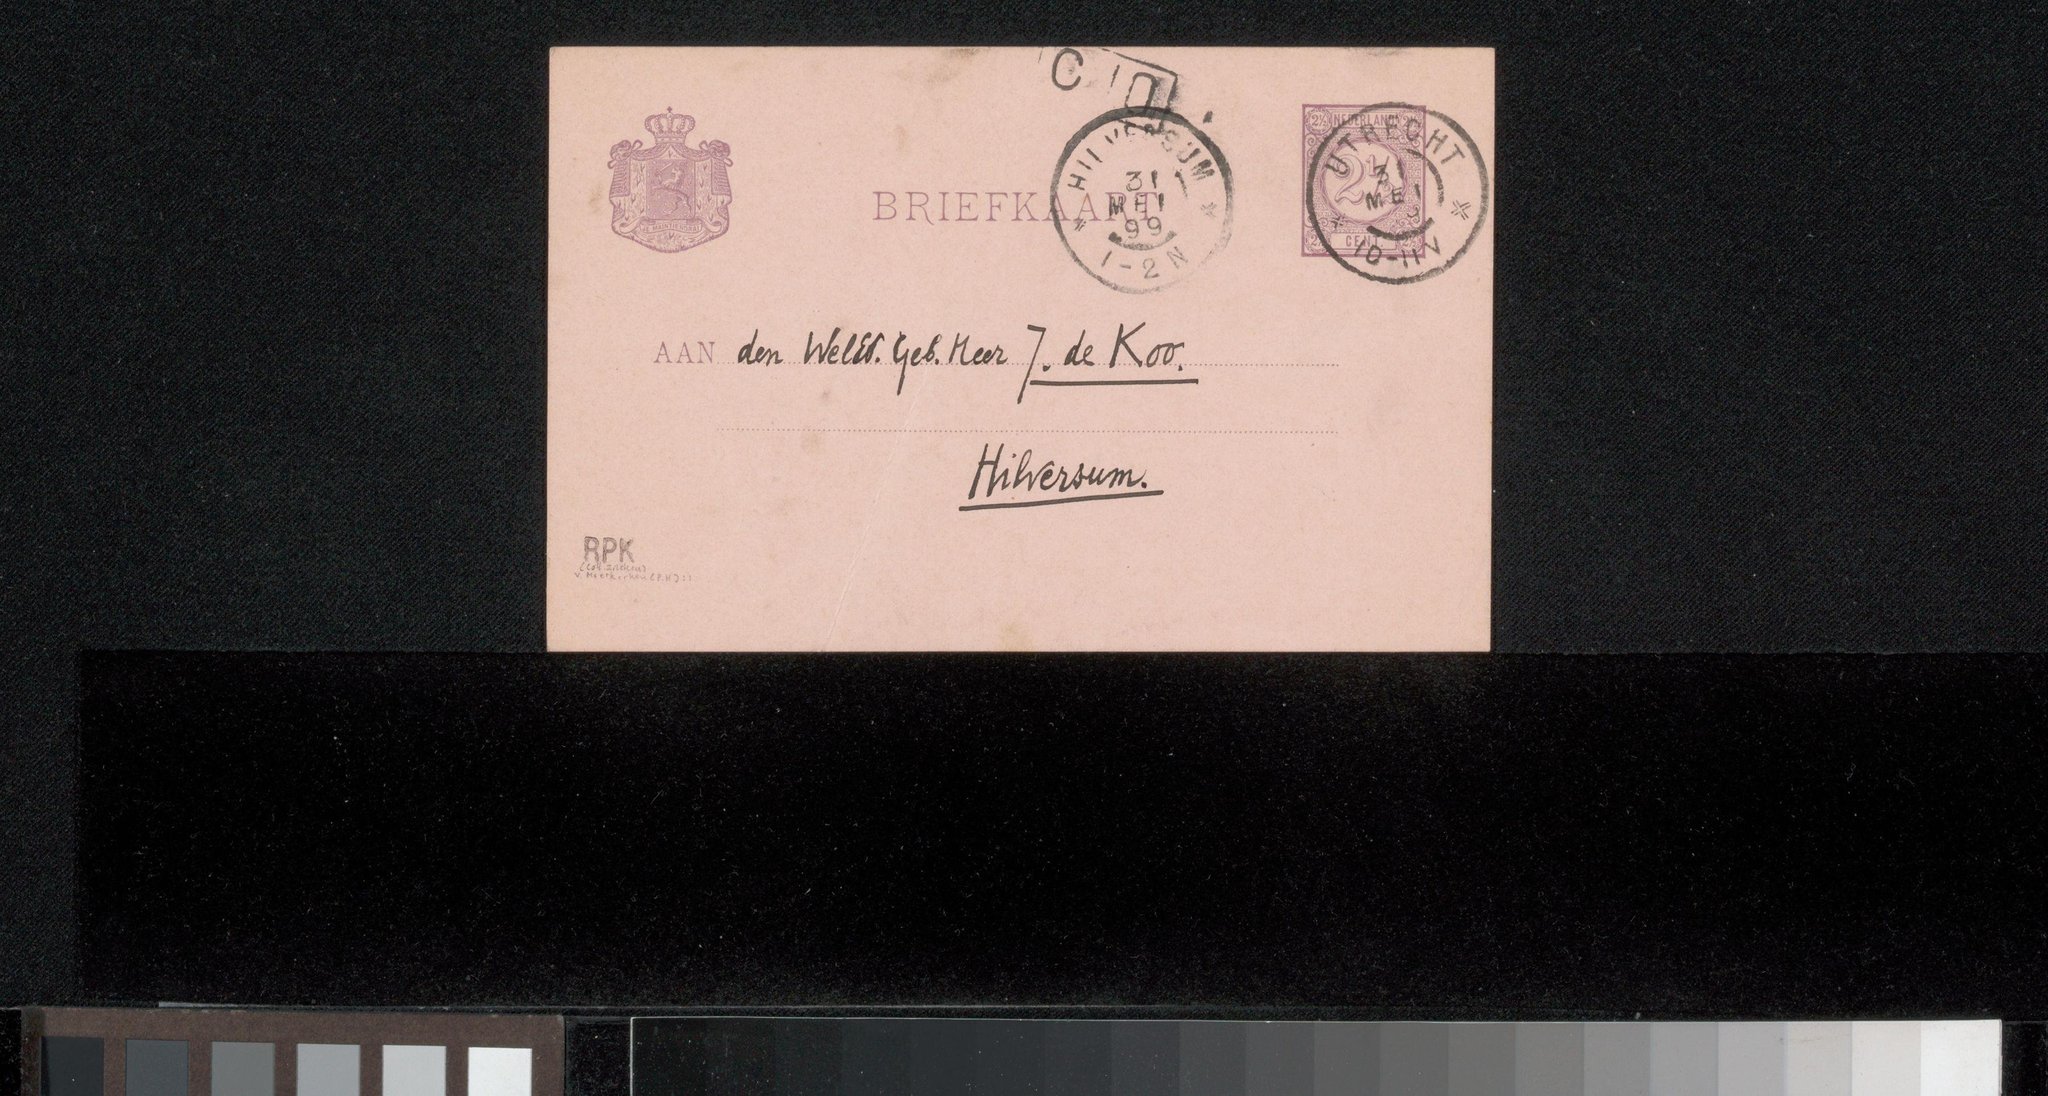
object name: postcard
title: Briefkaart aan Johannes de Koo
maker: pieter hendrik van moerkerken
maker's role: print maker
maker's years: 1877-1951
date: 1899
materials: cardboard, ink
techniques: pen, writing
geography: utrecht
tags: liège, johannes de koo, painter, draughtsman, philip zilcken, printed matter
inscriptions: collector's mark: ‘RPK’